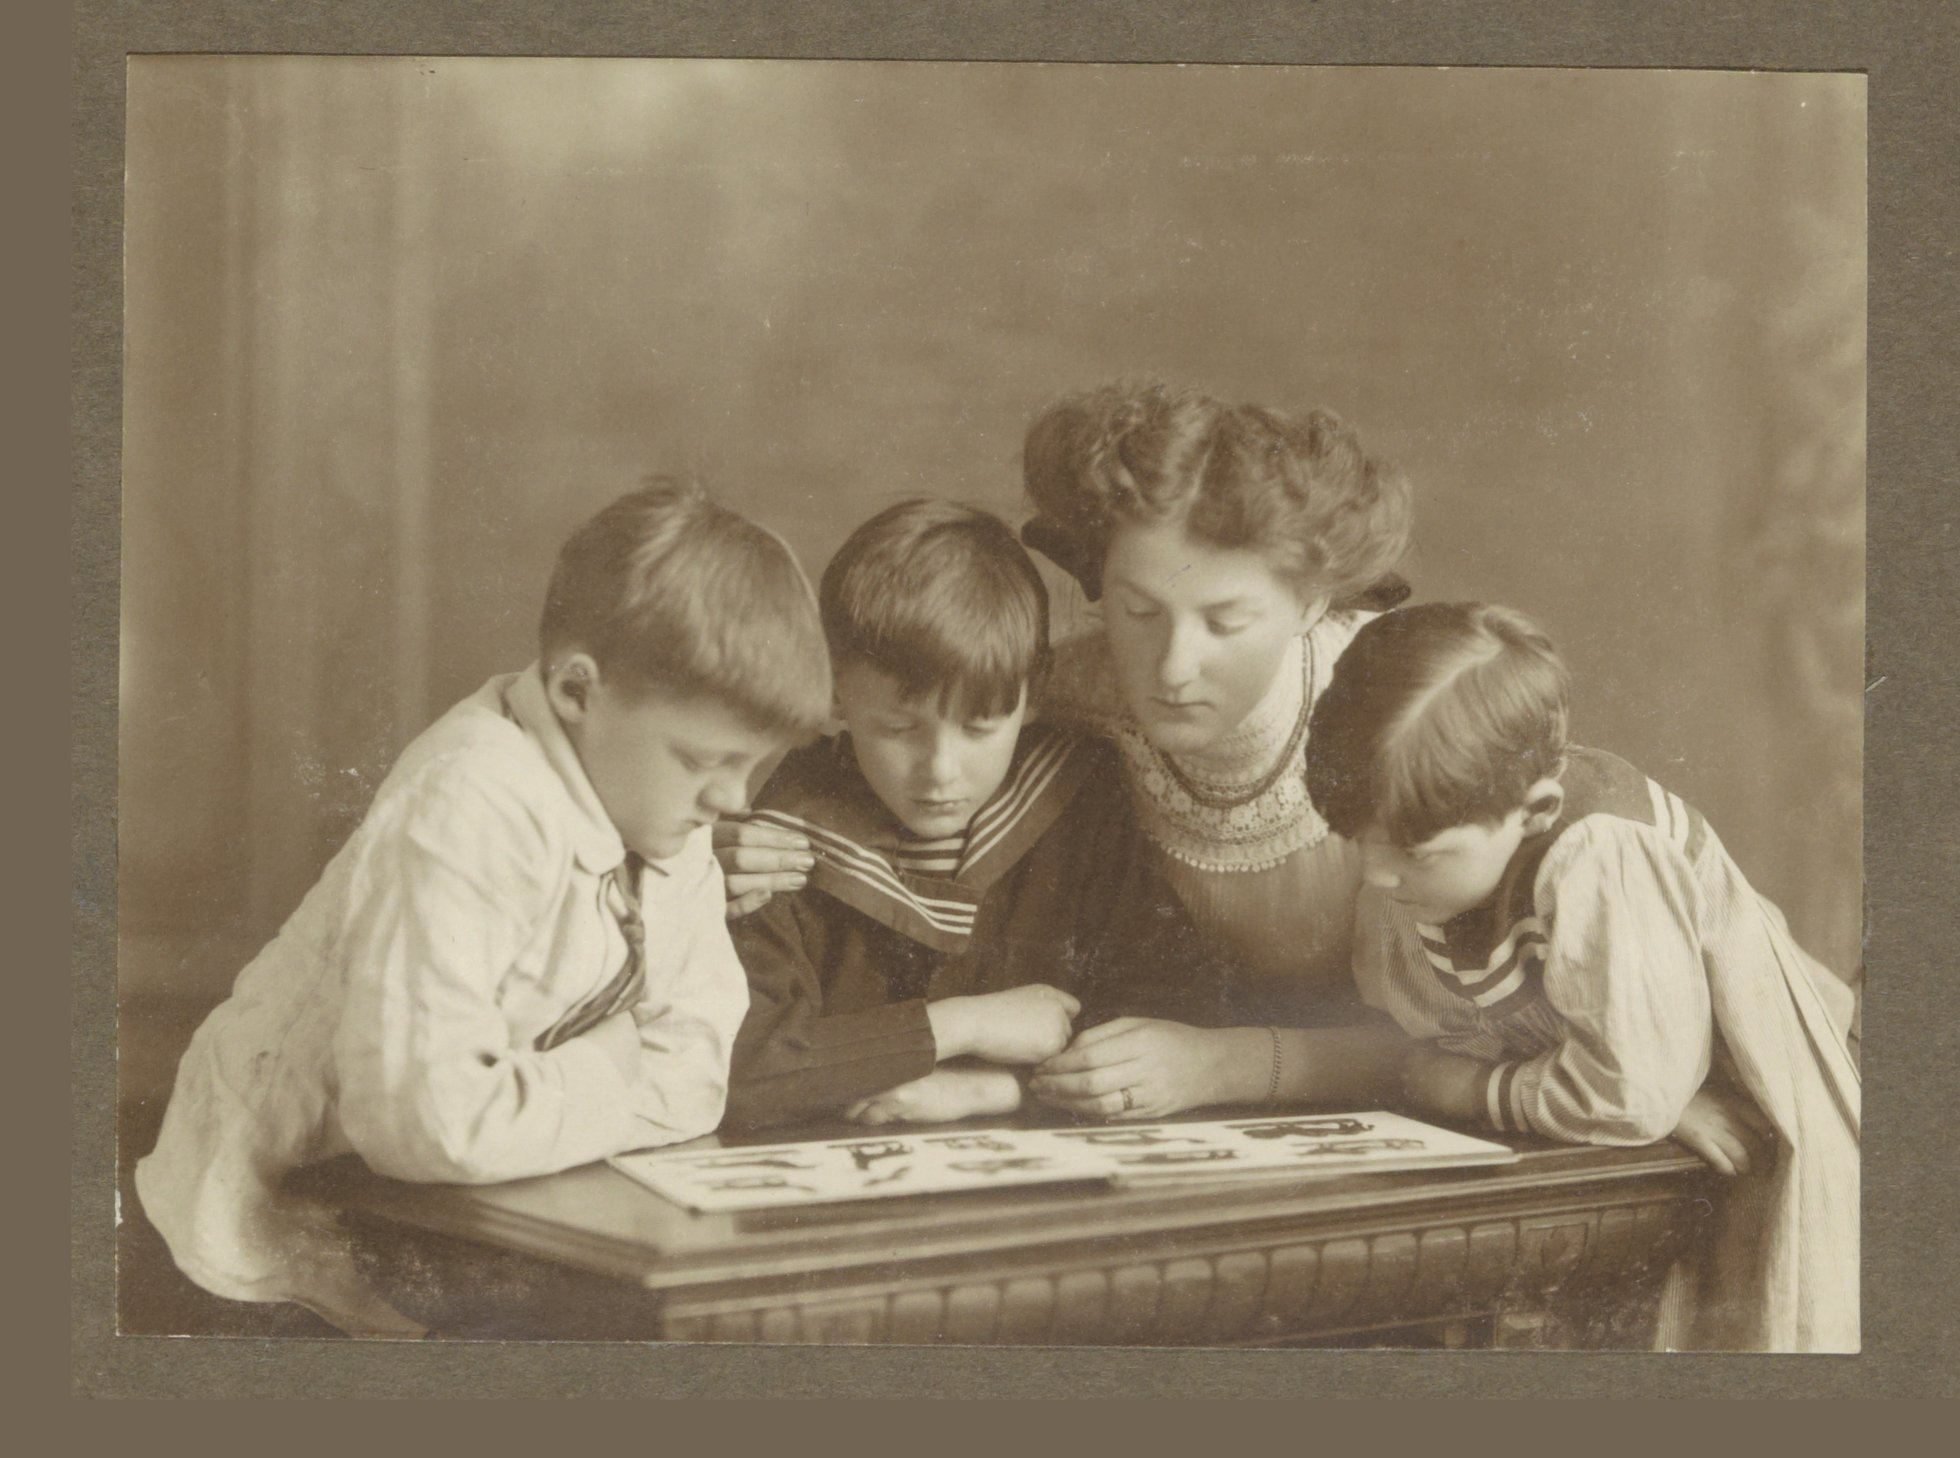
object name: photograph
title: Groepsportret van de kinderen Vermeulen, een plaatjesboek bekijkend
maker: cornelis johannes lodewicus vermeulen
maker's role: fotograaf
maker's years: 1861-1936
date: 1900-1920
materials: paper, photographic support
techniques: gelatin silver print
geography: the hague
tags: reading, parents with their children, reading a picture book, the hague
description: Onderdeel van Fotoalbum met opnames van het gezin en het huis van fotograaf C.J.L. Vermeulen in Den Haag.